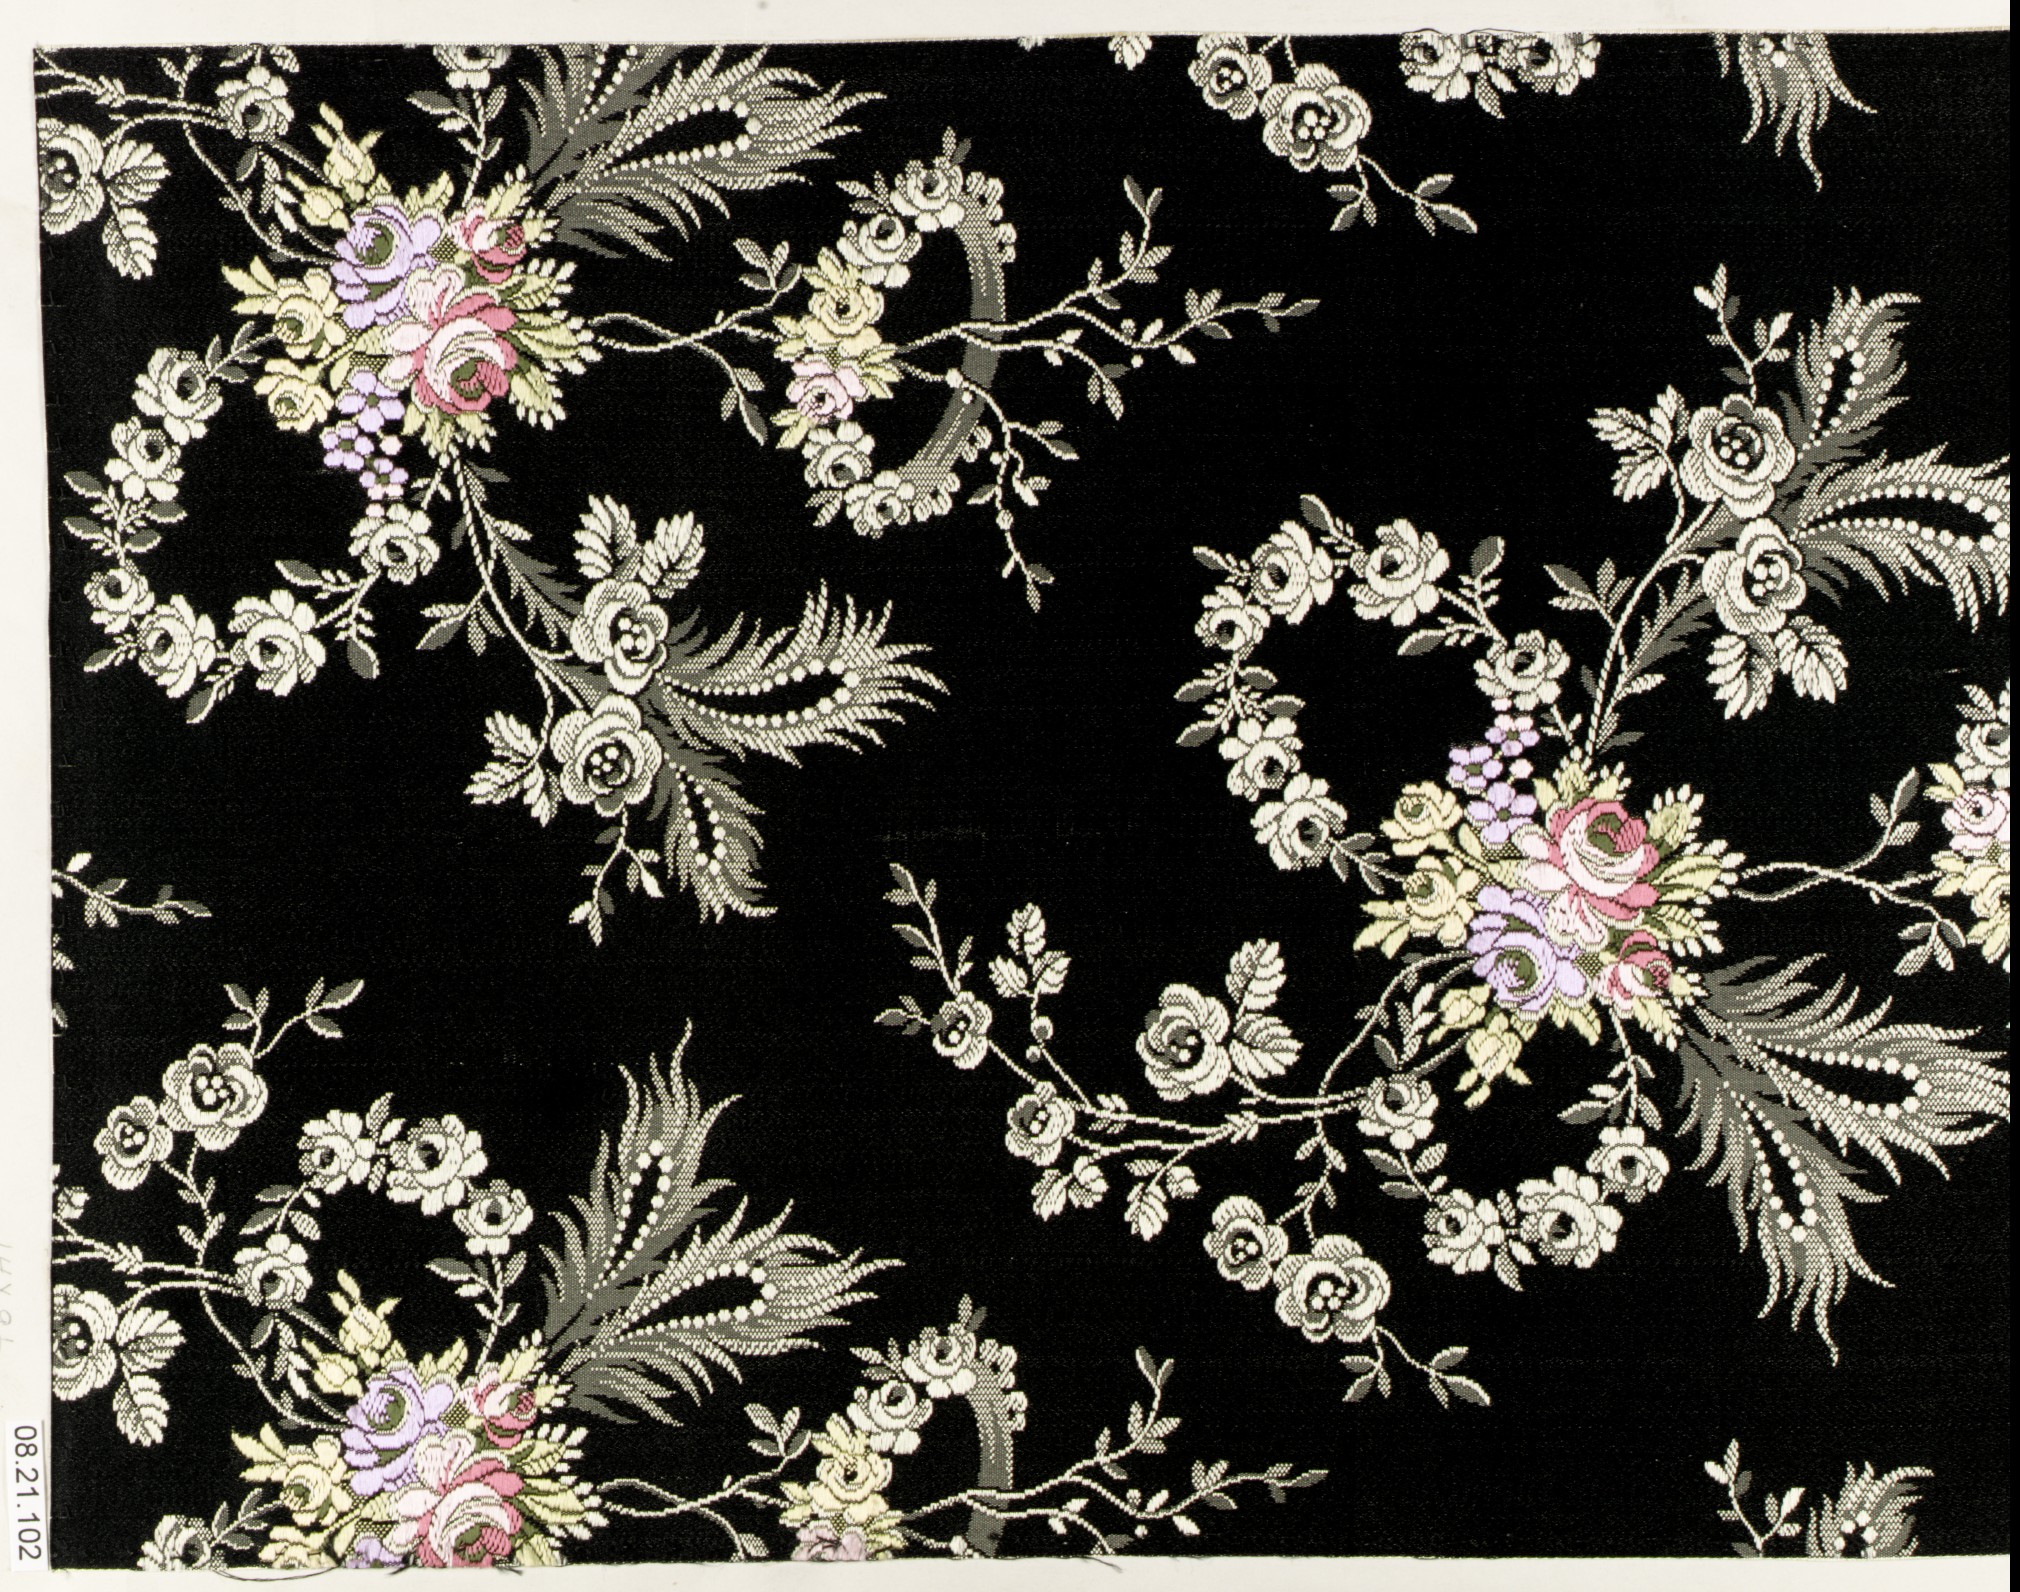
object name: textile sample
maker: Anonymous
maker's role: designer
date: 1900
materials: silk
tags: flowers